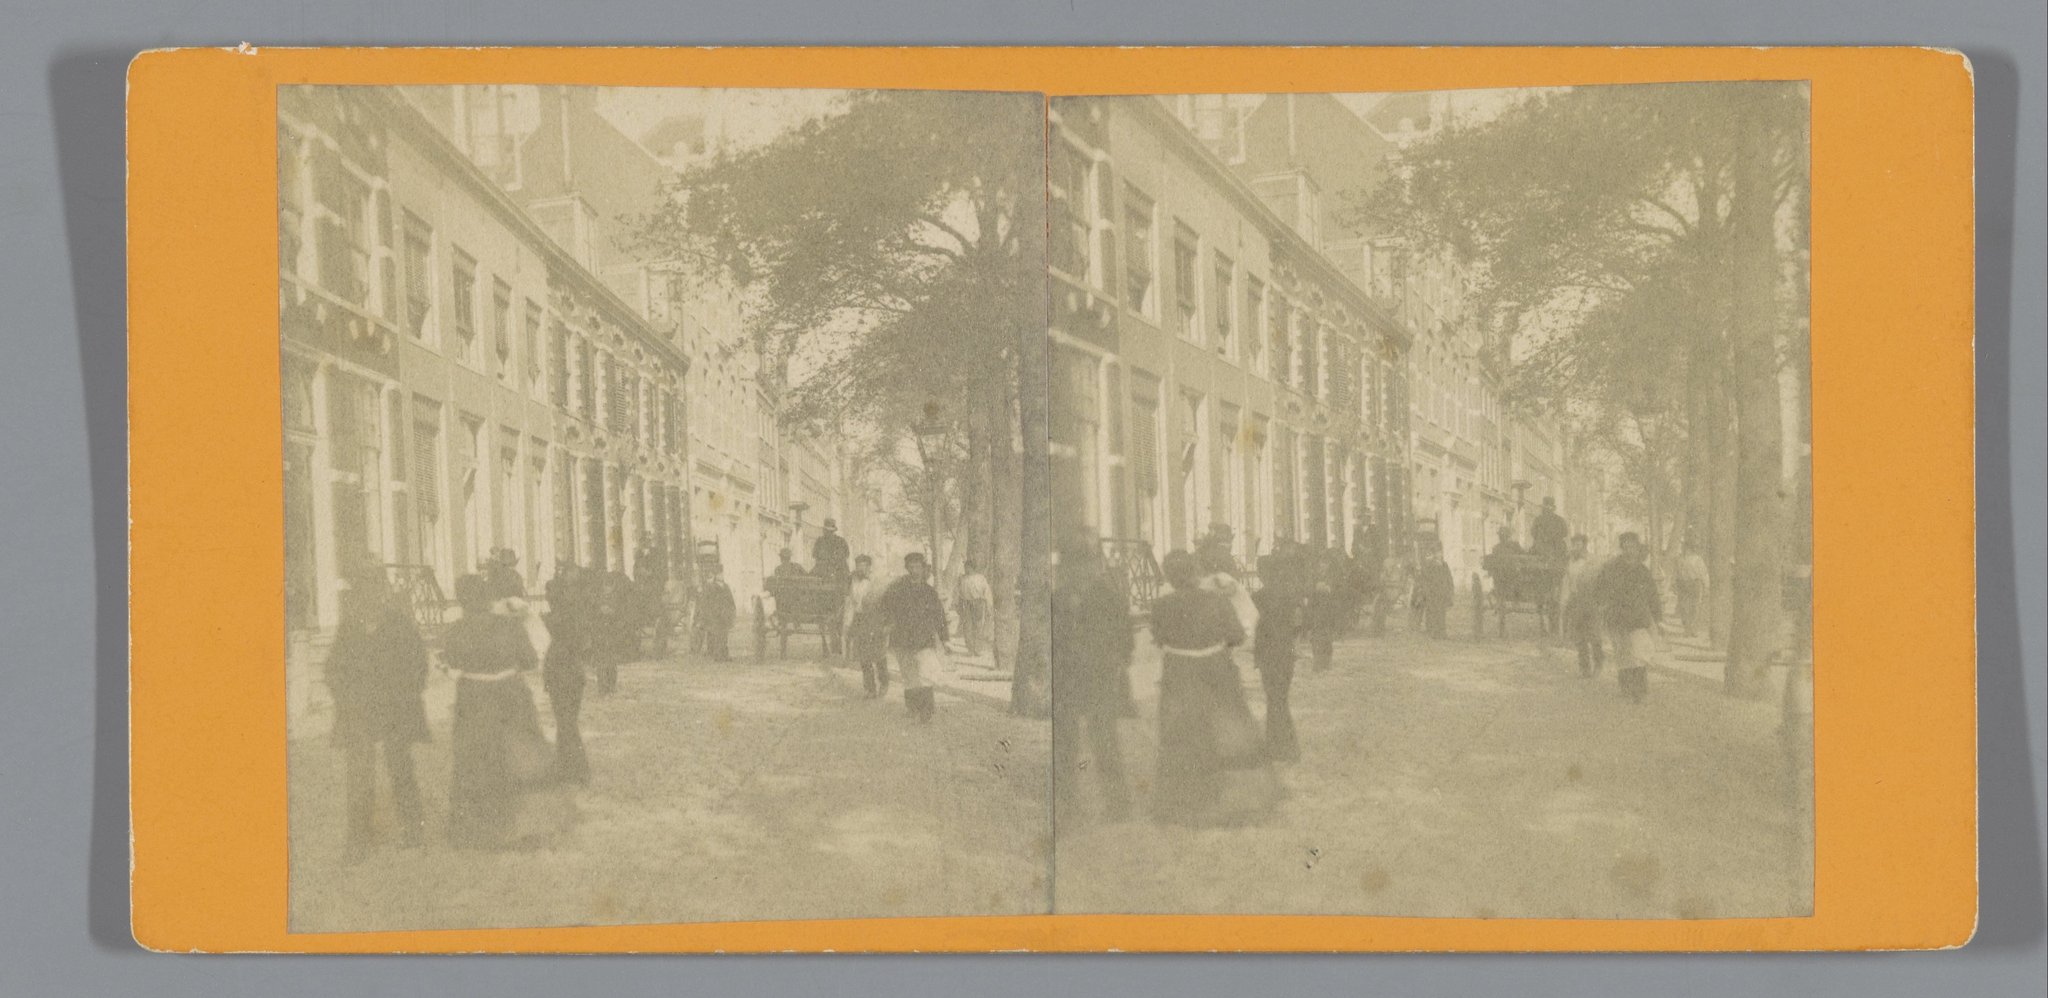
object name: stereograph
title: Straattafereel met voorbijgangers en koetsen in een stad, Nederland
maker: Anonymous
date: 1879-1910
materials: cardboard, paper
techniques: albumen print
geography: netherlands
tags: street, netherlands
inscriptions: number: ‘25’